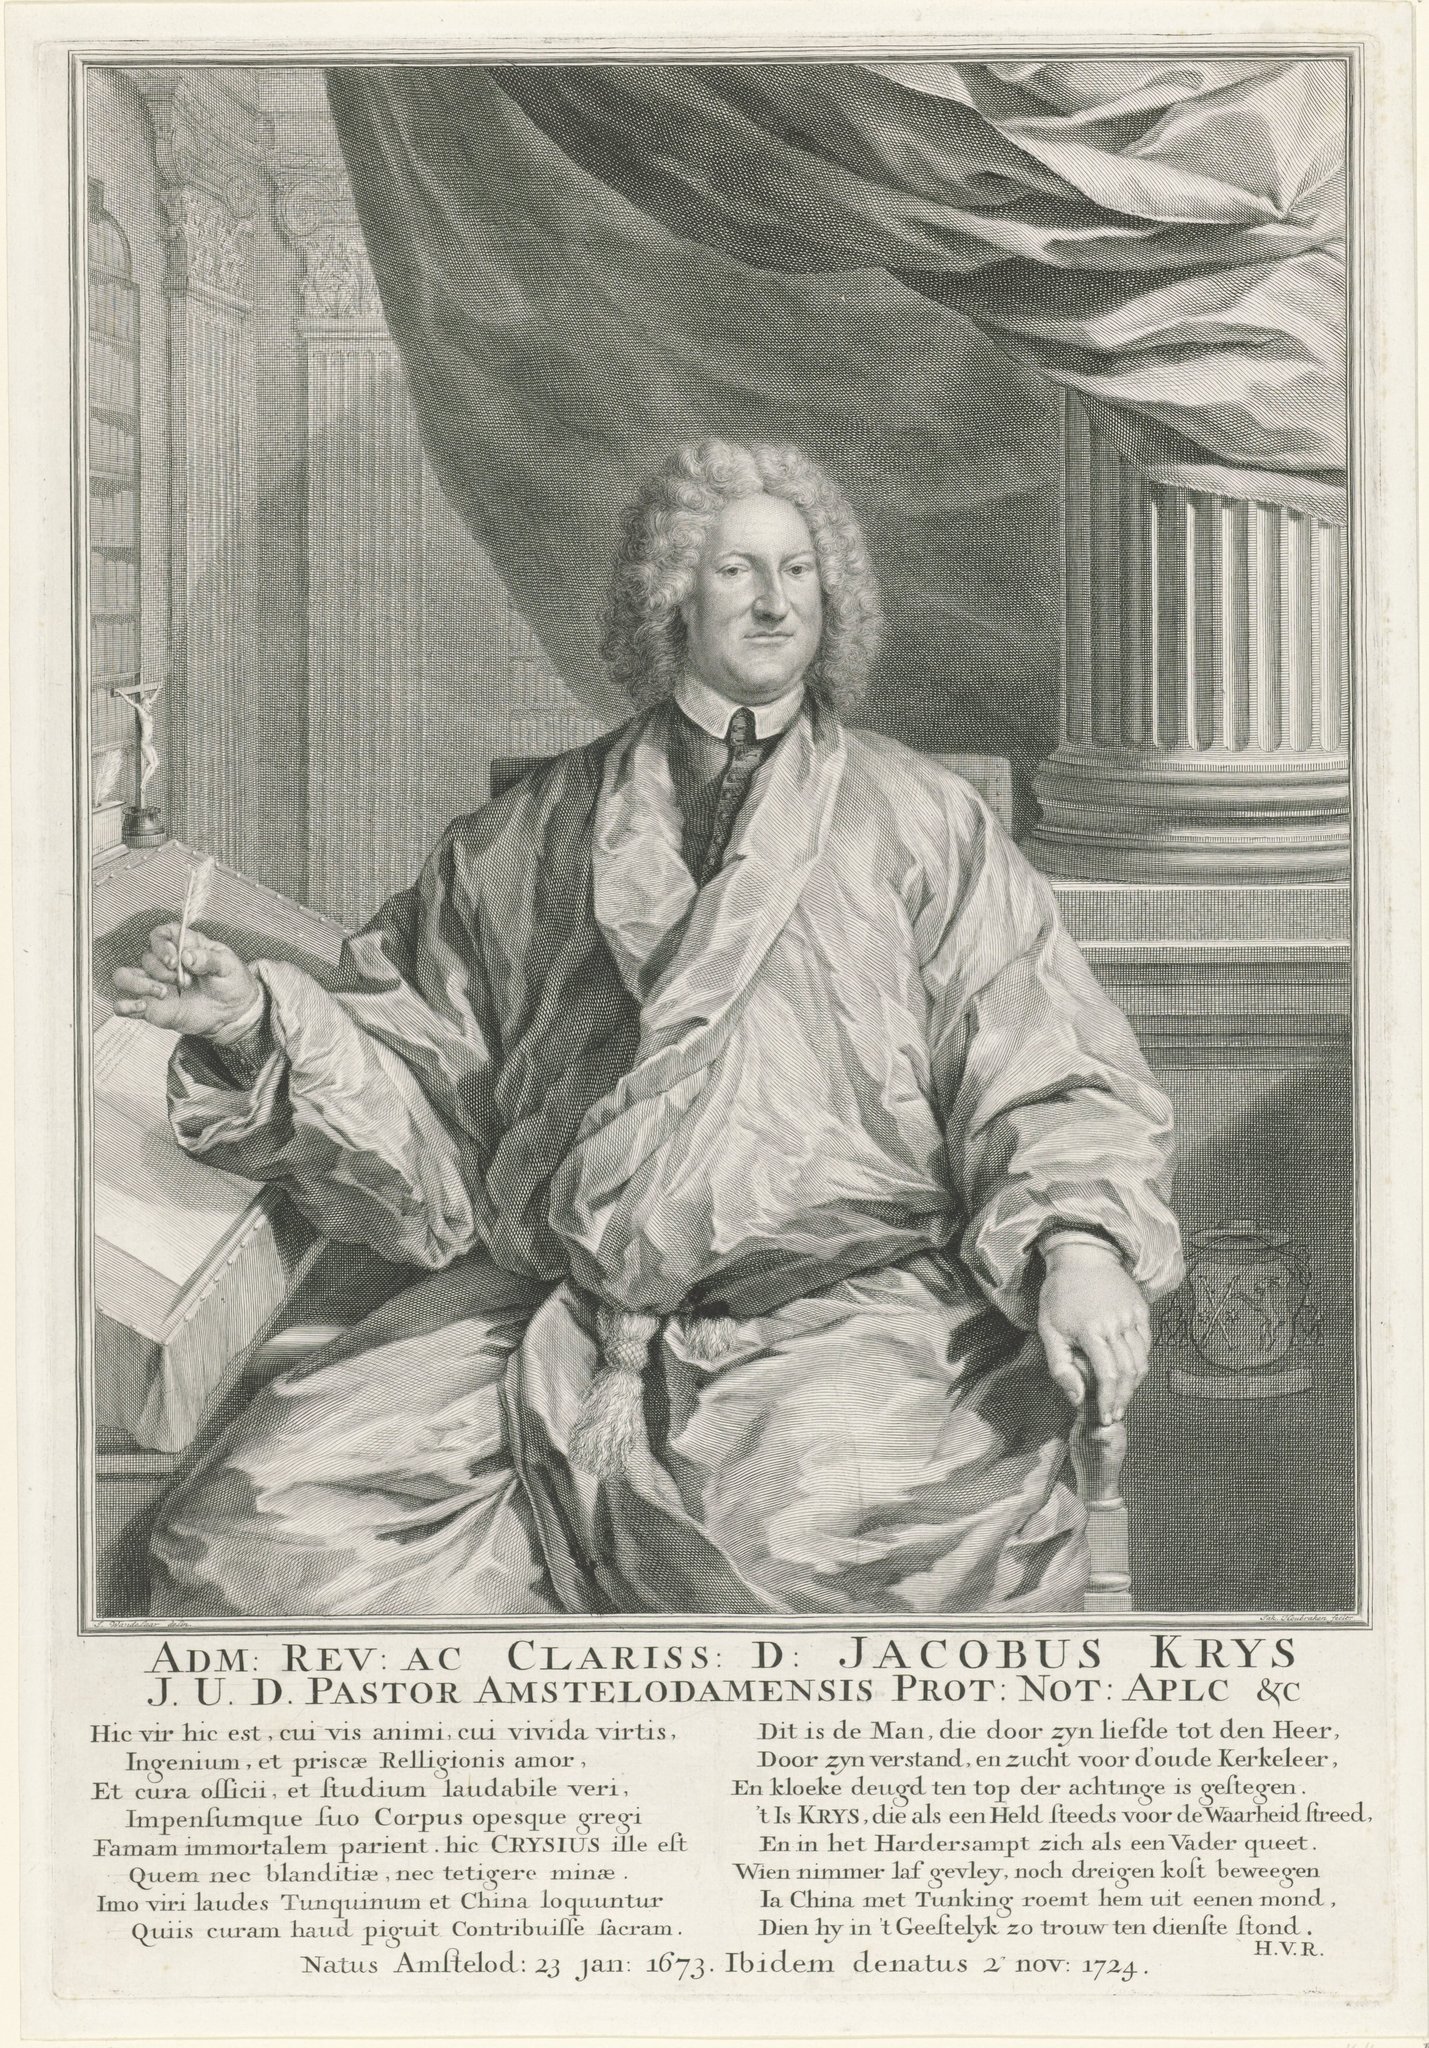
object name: print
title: Portret van Jacobus Ignatius Krijs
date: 1724-1780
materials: paper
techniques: engraving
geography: amsterdam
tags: amsterdam, quill, crucifix ~ personal devotion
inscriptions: collector's mark: Lugt 240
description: Jacobus Ignatius Krijs zittend aan een schrijftafel, waarop een crucifix. In zijn hand een schrijfveer. Achter hem een zuil en een gordijn, daarachter twee pilasters en boekenkasten. Rechts van hem een kerkelijk wapen. Onder het portret zijn naam en gegevens in twee regels in het Latijn. Daaronder twee kolommen van elk acht regels; links in het Latijn en rechts in het Nederlands. Daaronder zijn geboorte- en sterfgegevens in een regel in het Latijn.